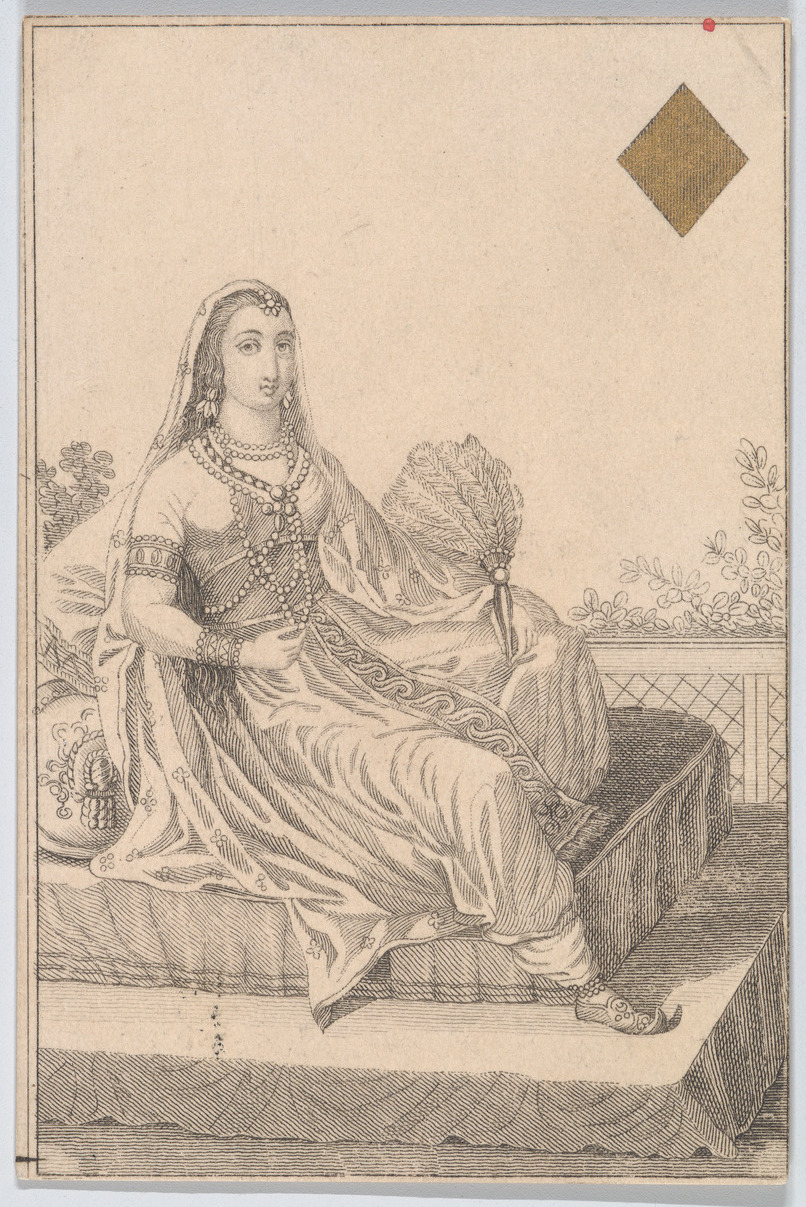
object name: print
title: Queen (Stutira from Persia), from "Court Game of Geography"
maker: william and henry rock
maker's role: publisher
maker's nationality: british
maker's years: 1821-1884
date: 1838-1855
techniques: engraving, etching, hand coloring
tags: queens,playing cards